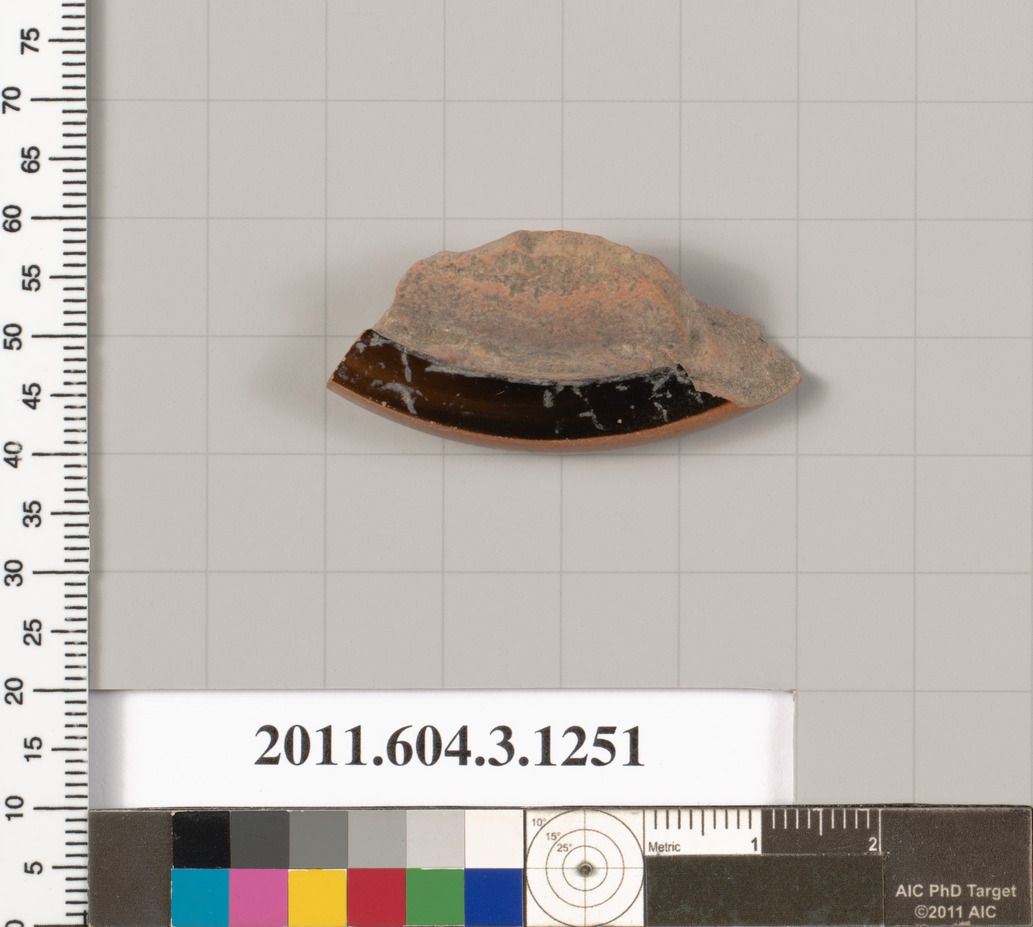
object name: kyathos fragment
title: Terracotta fragment of a kyathos (cup-shaped ladle)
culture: greek, attic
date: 534-468 BCE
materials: terracotta